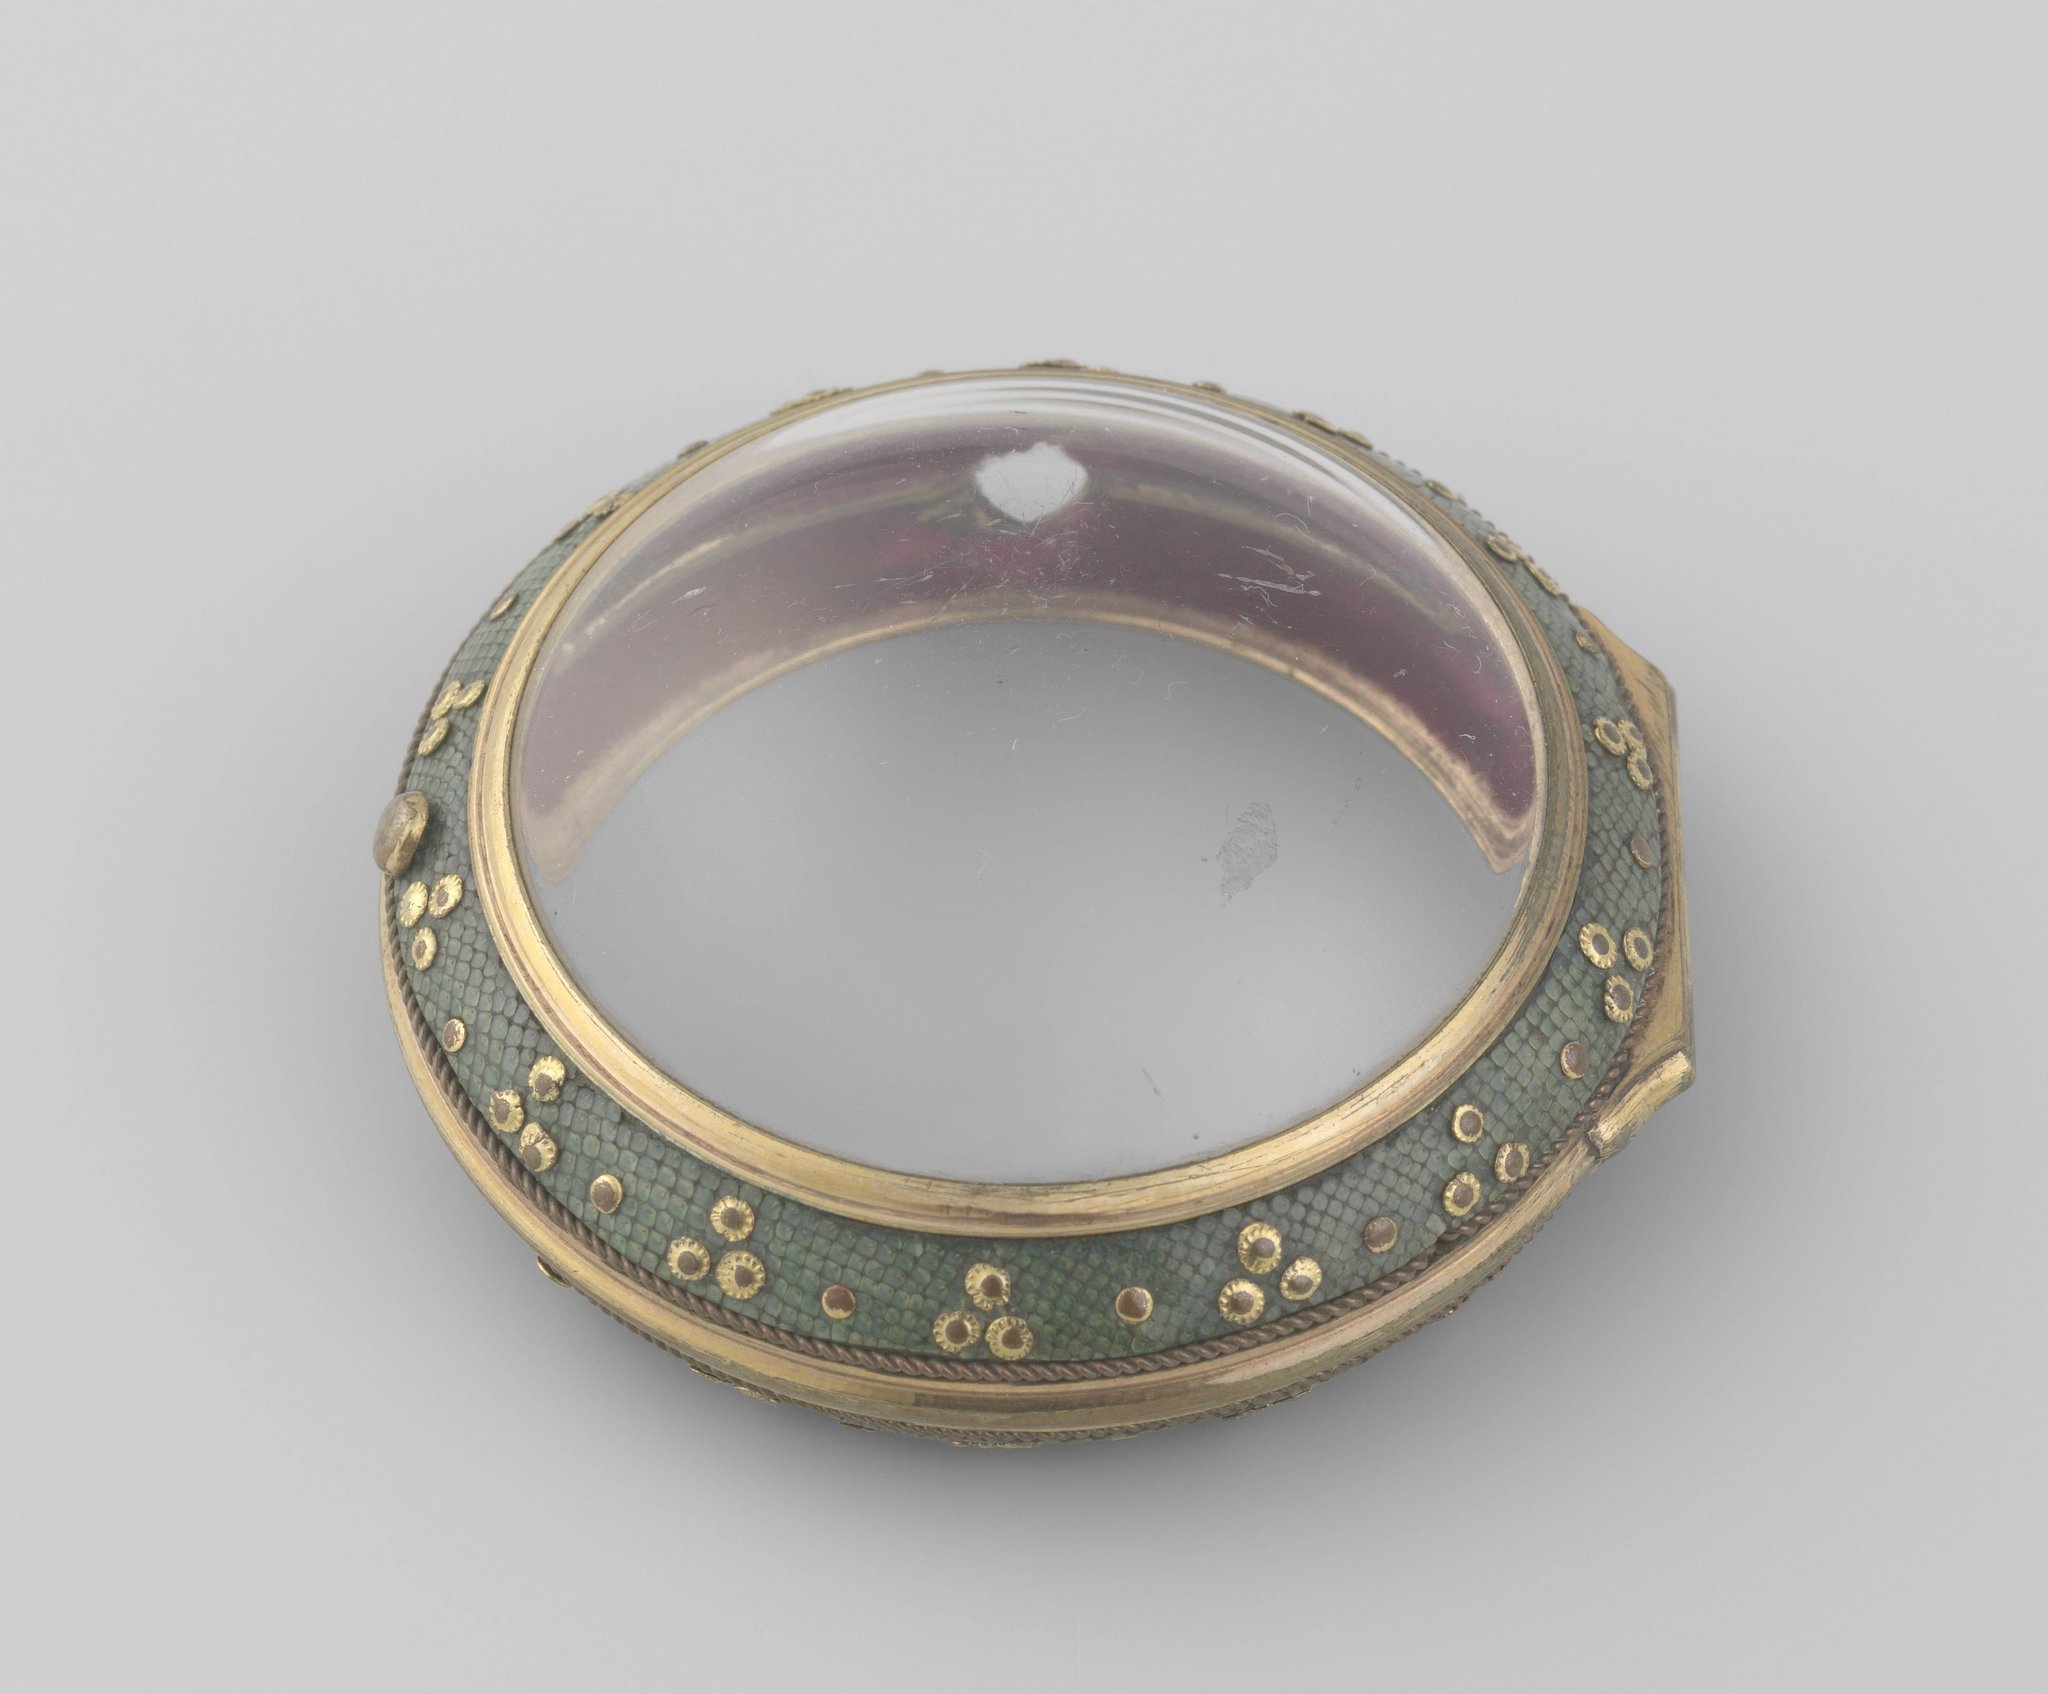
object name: buitenkast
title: Pocket watch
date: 1755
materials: gold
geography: paris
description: Buitenkast van groen roggenleer en goud.